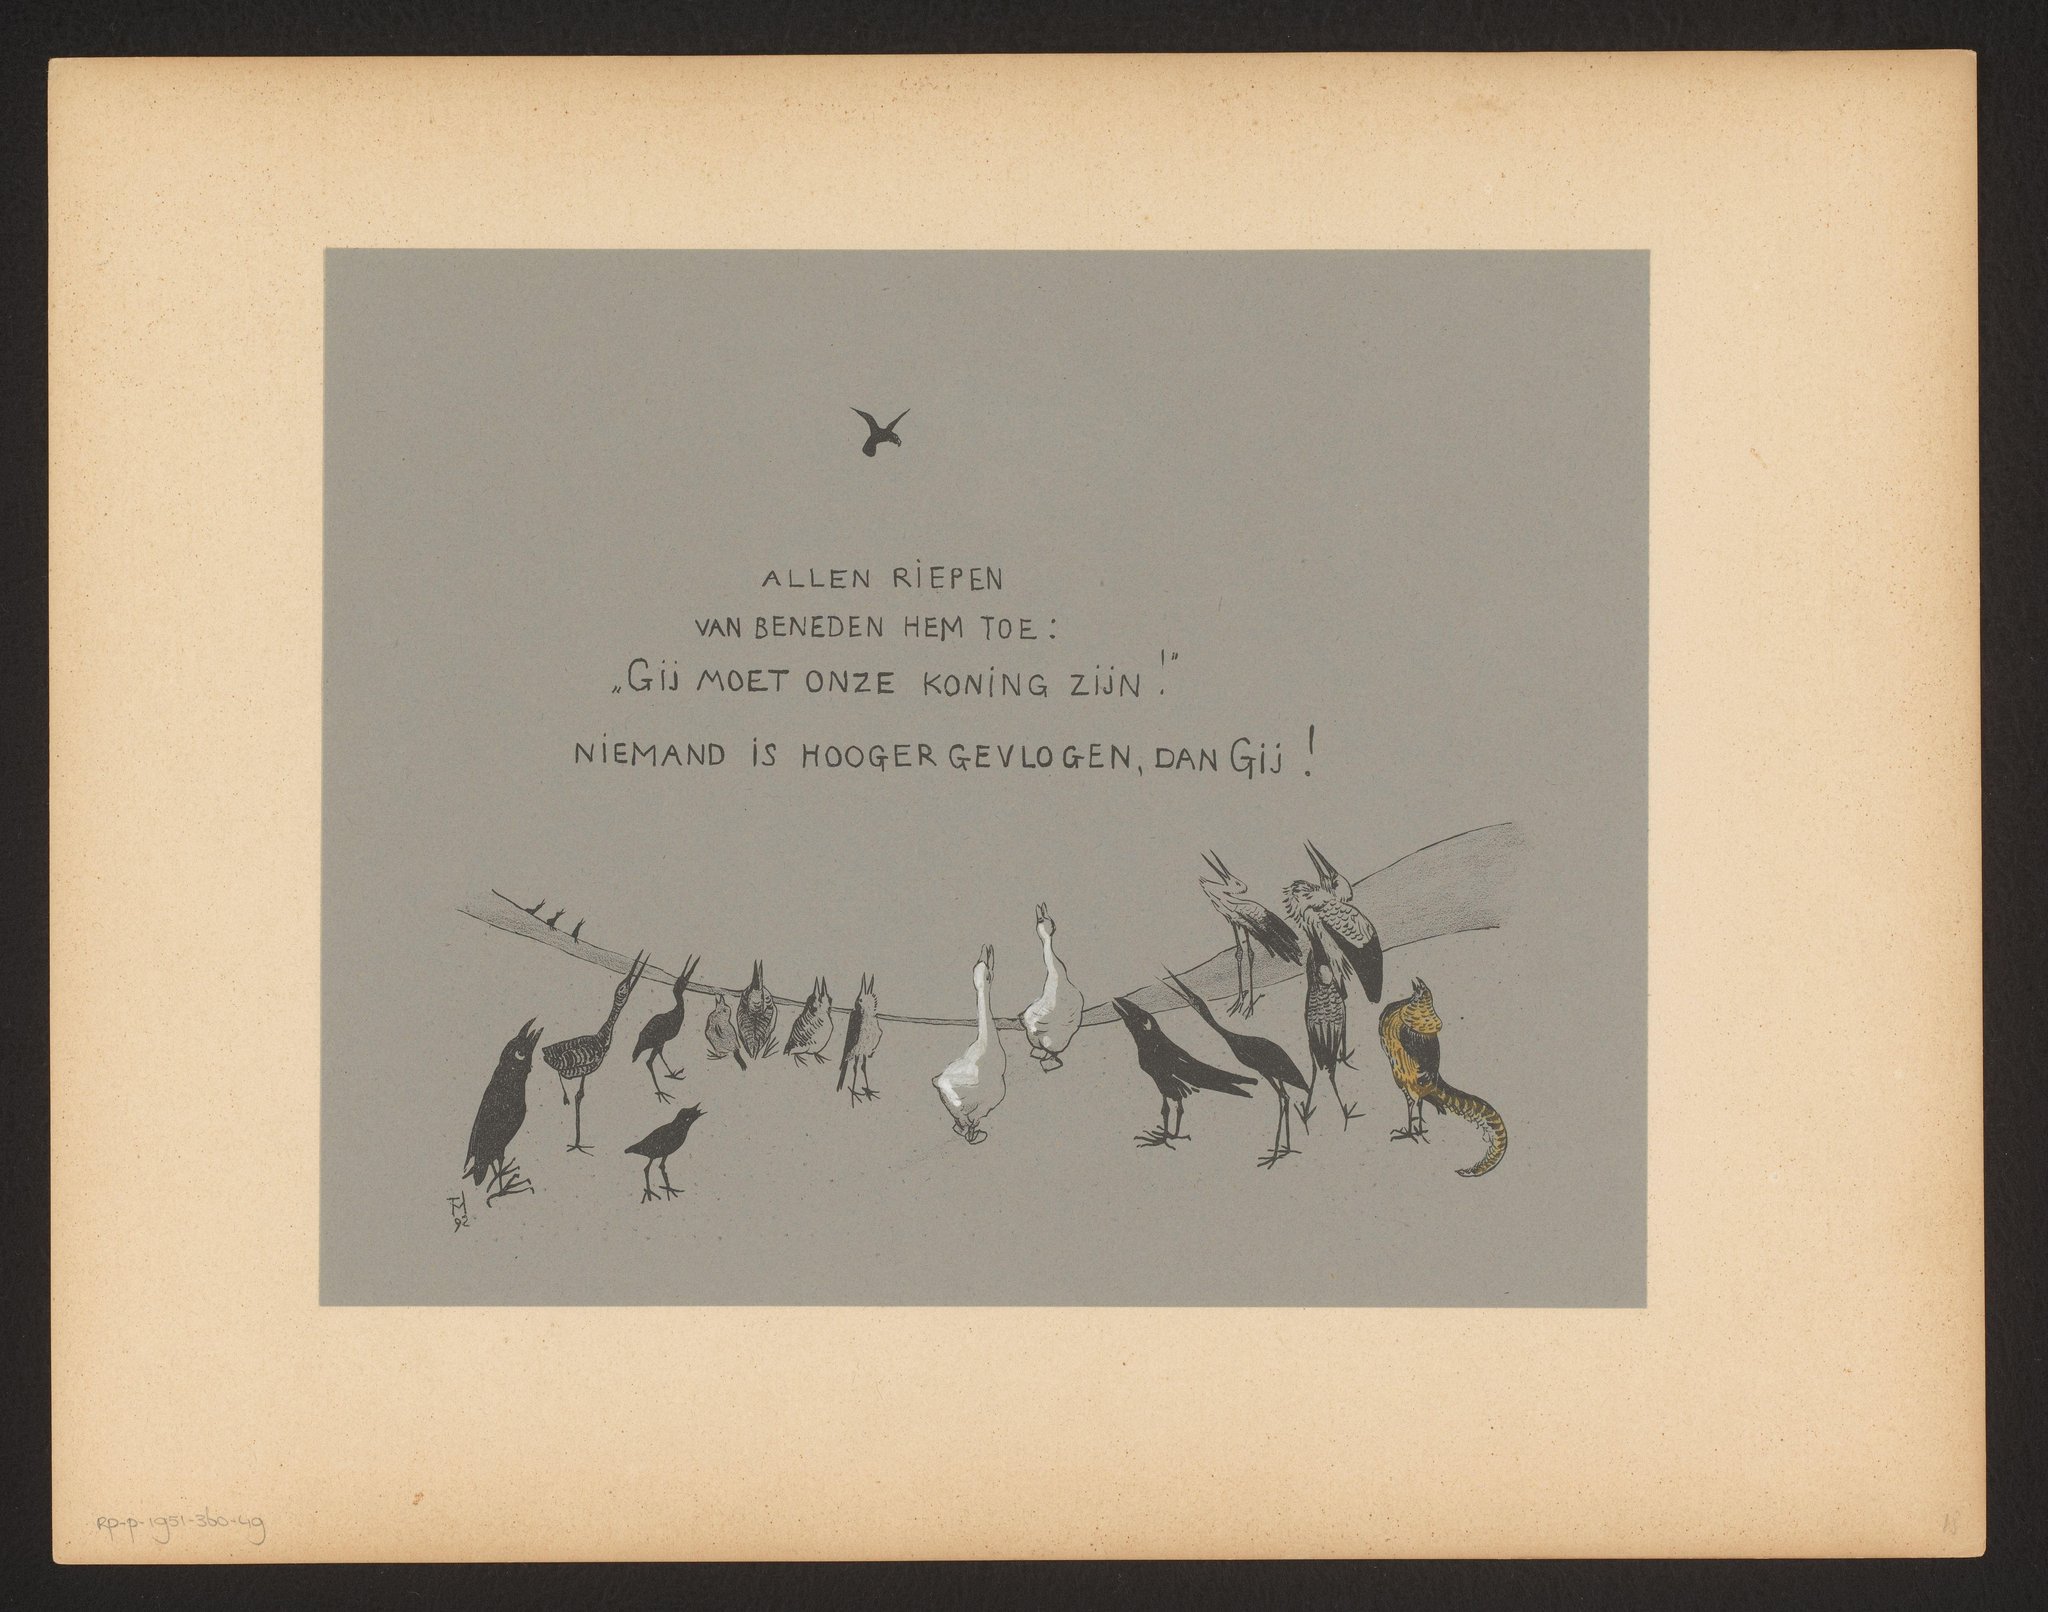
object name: print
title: Vanaf de grond kijkt een groep vogels op naar een biddende arend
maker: theo van hoytema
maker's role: draughtsman, painter, print maker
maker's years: 1863-1917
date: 1892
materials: paper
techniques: hand coloring, lithograph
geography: the hague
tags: predatory birds: eagle, water-birds: goose, shore-birds and wading-birds: stork, walker and runner birds: pheasant, groups of birds, shore-birds and wading-birds: bittern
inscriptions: date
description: Onder andere roerdomp, kraai, fazant, ooievaar en gans.